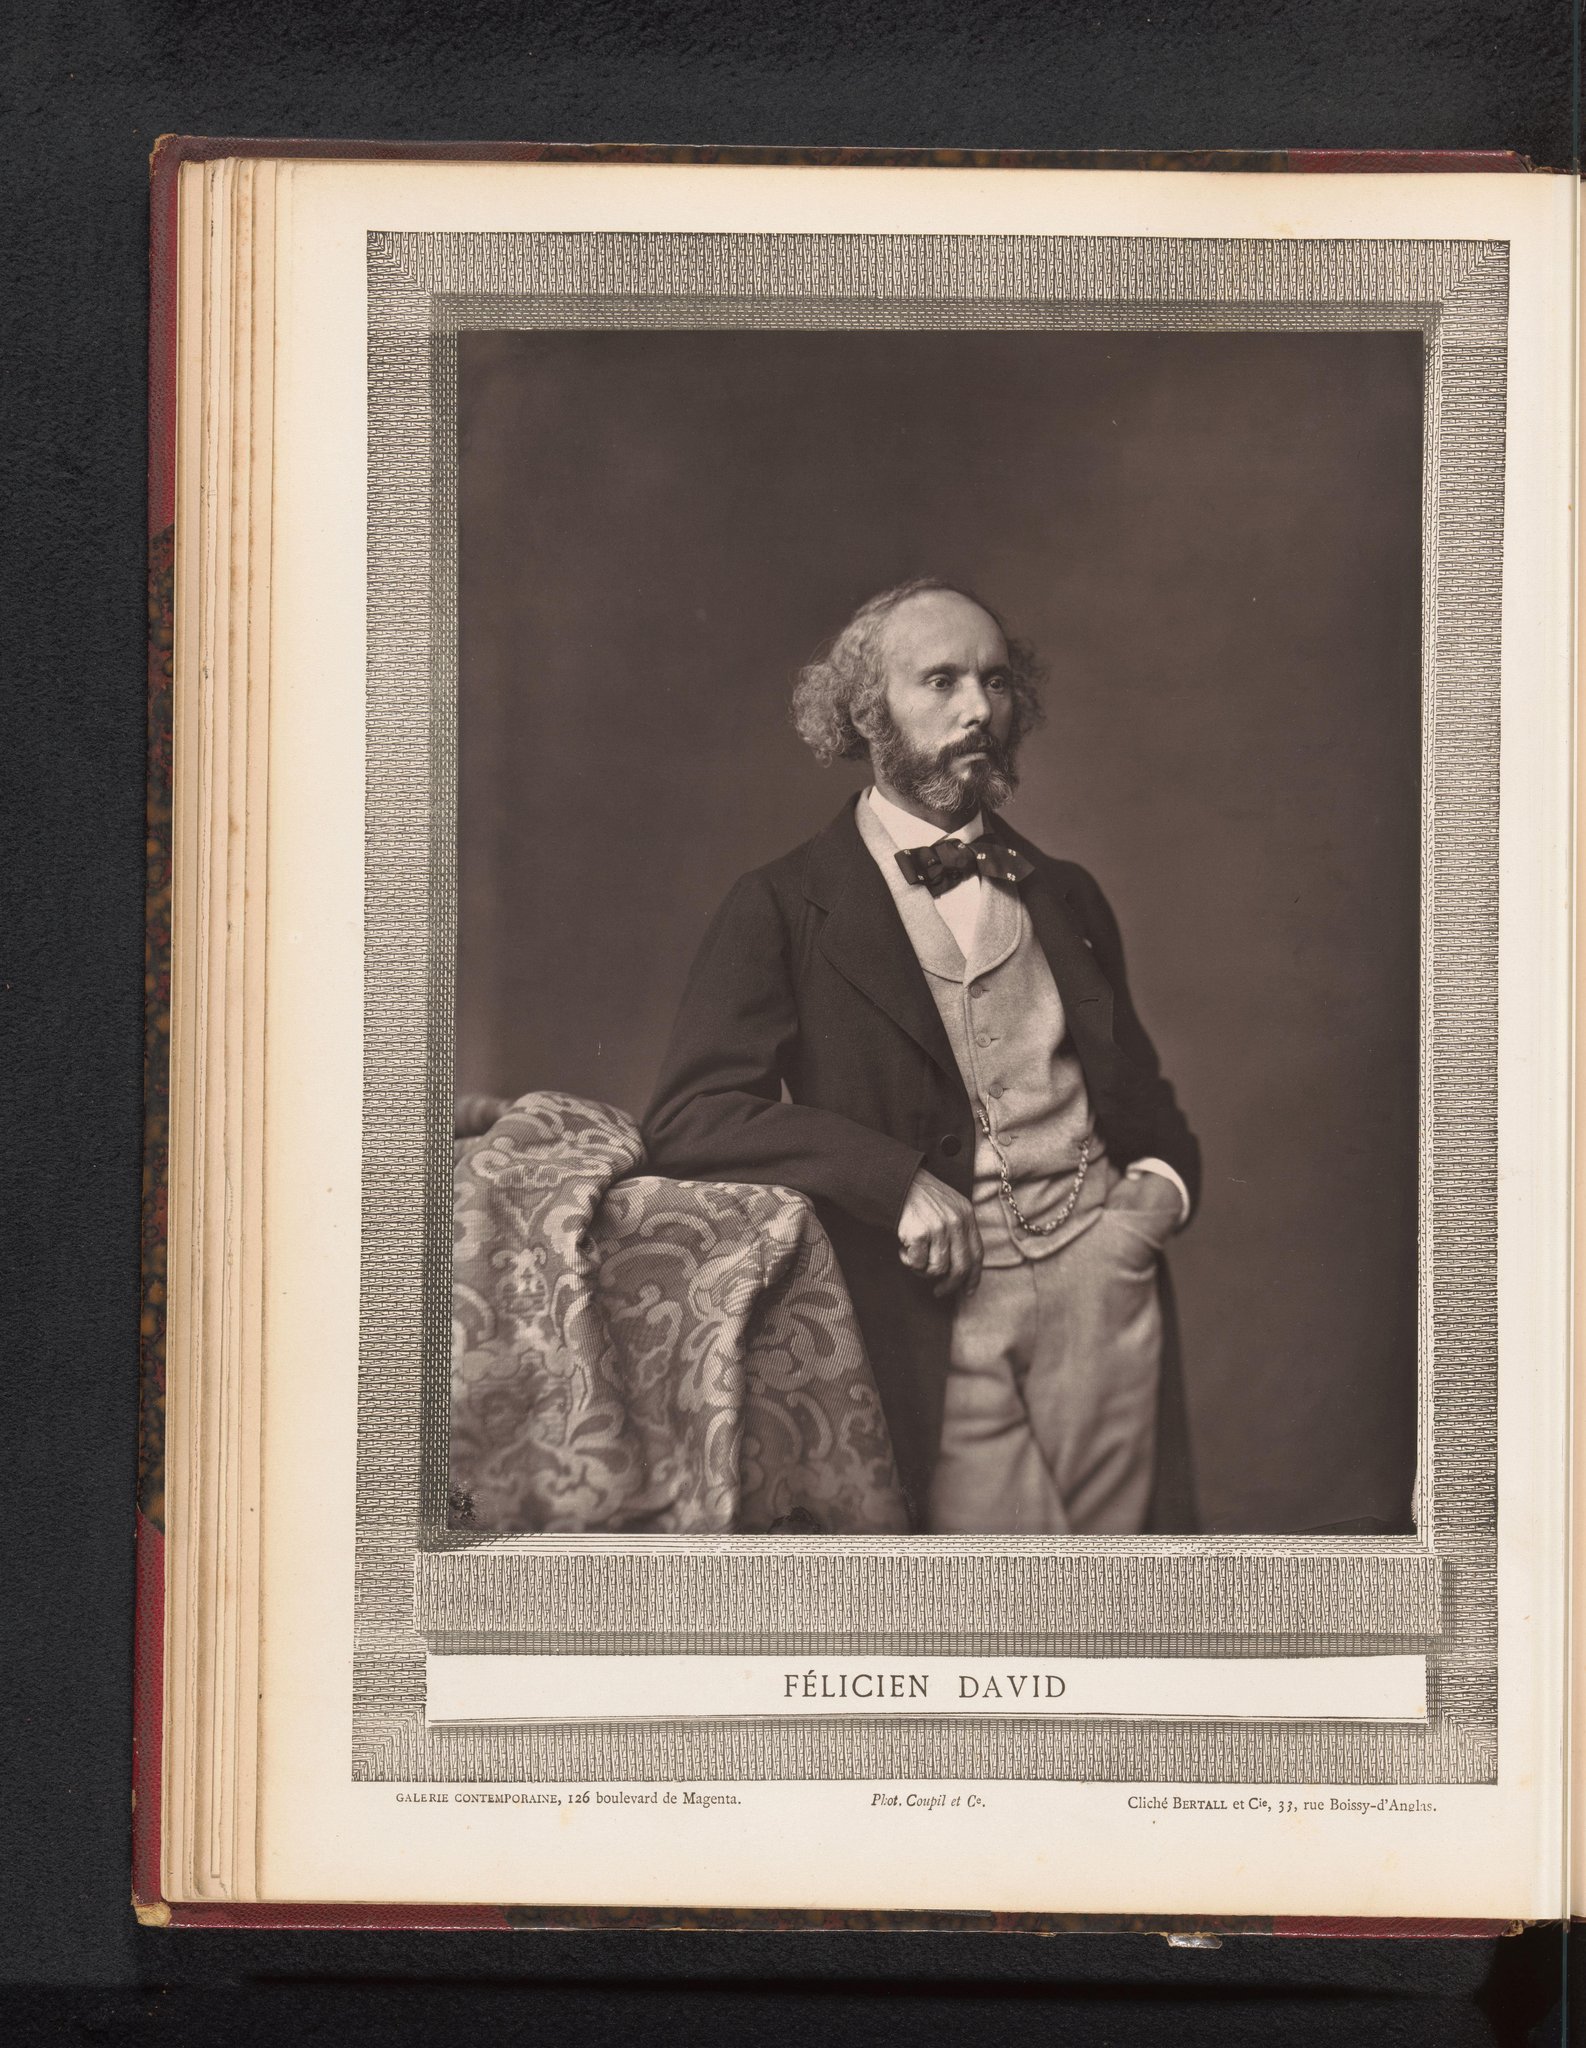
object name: page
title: Portret van Félicien-César David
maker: Anonymous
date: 1871-1876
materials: paper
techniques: woodburytype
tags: adult man, historical persons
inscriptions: inscription: ‘Galerie Contemporaine, 126, boulevard de Magenta.’